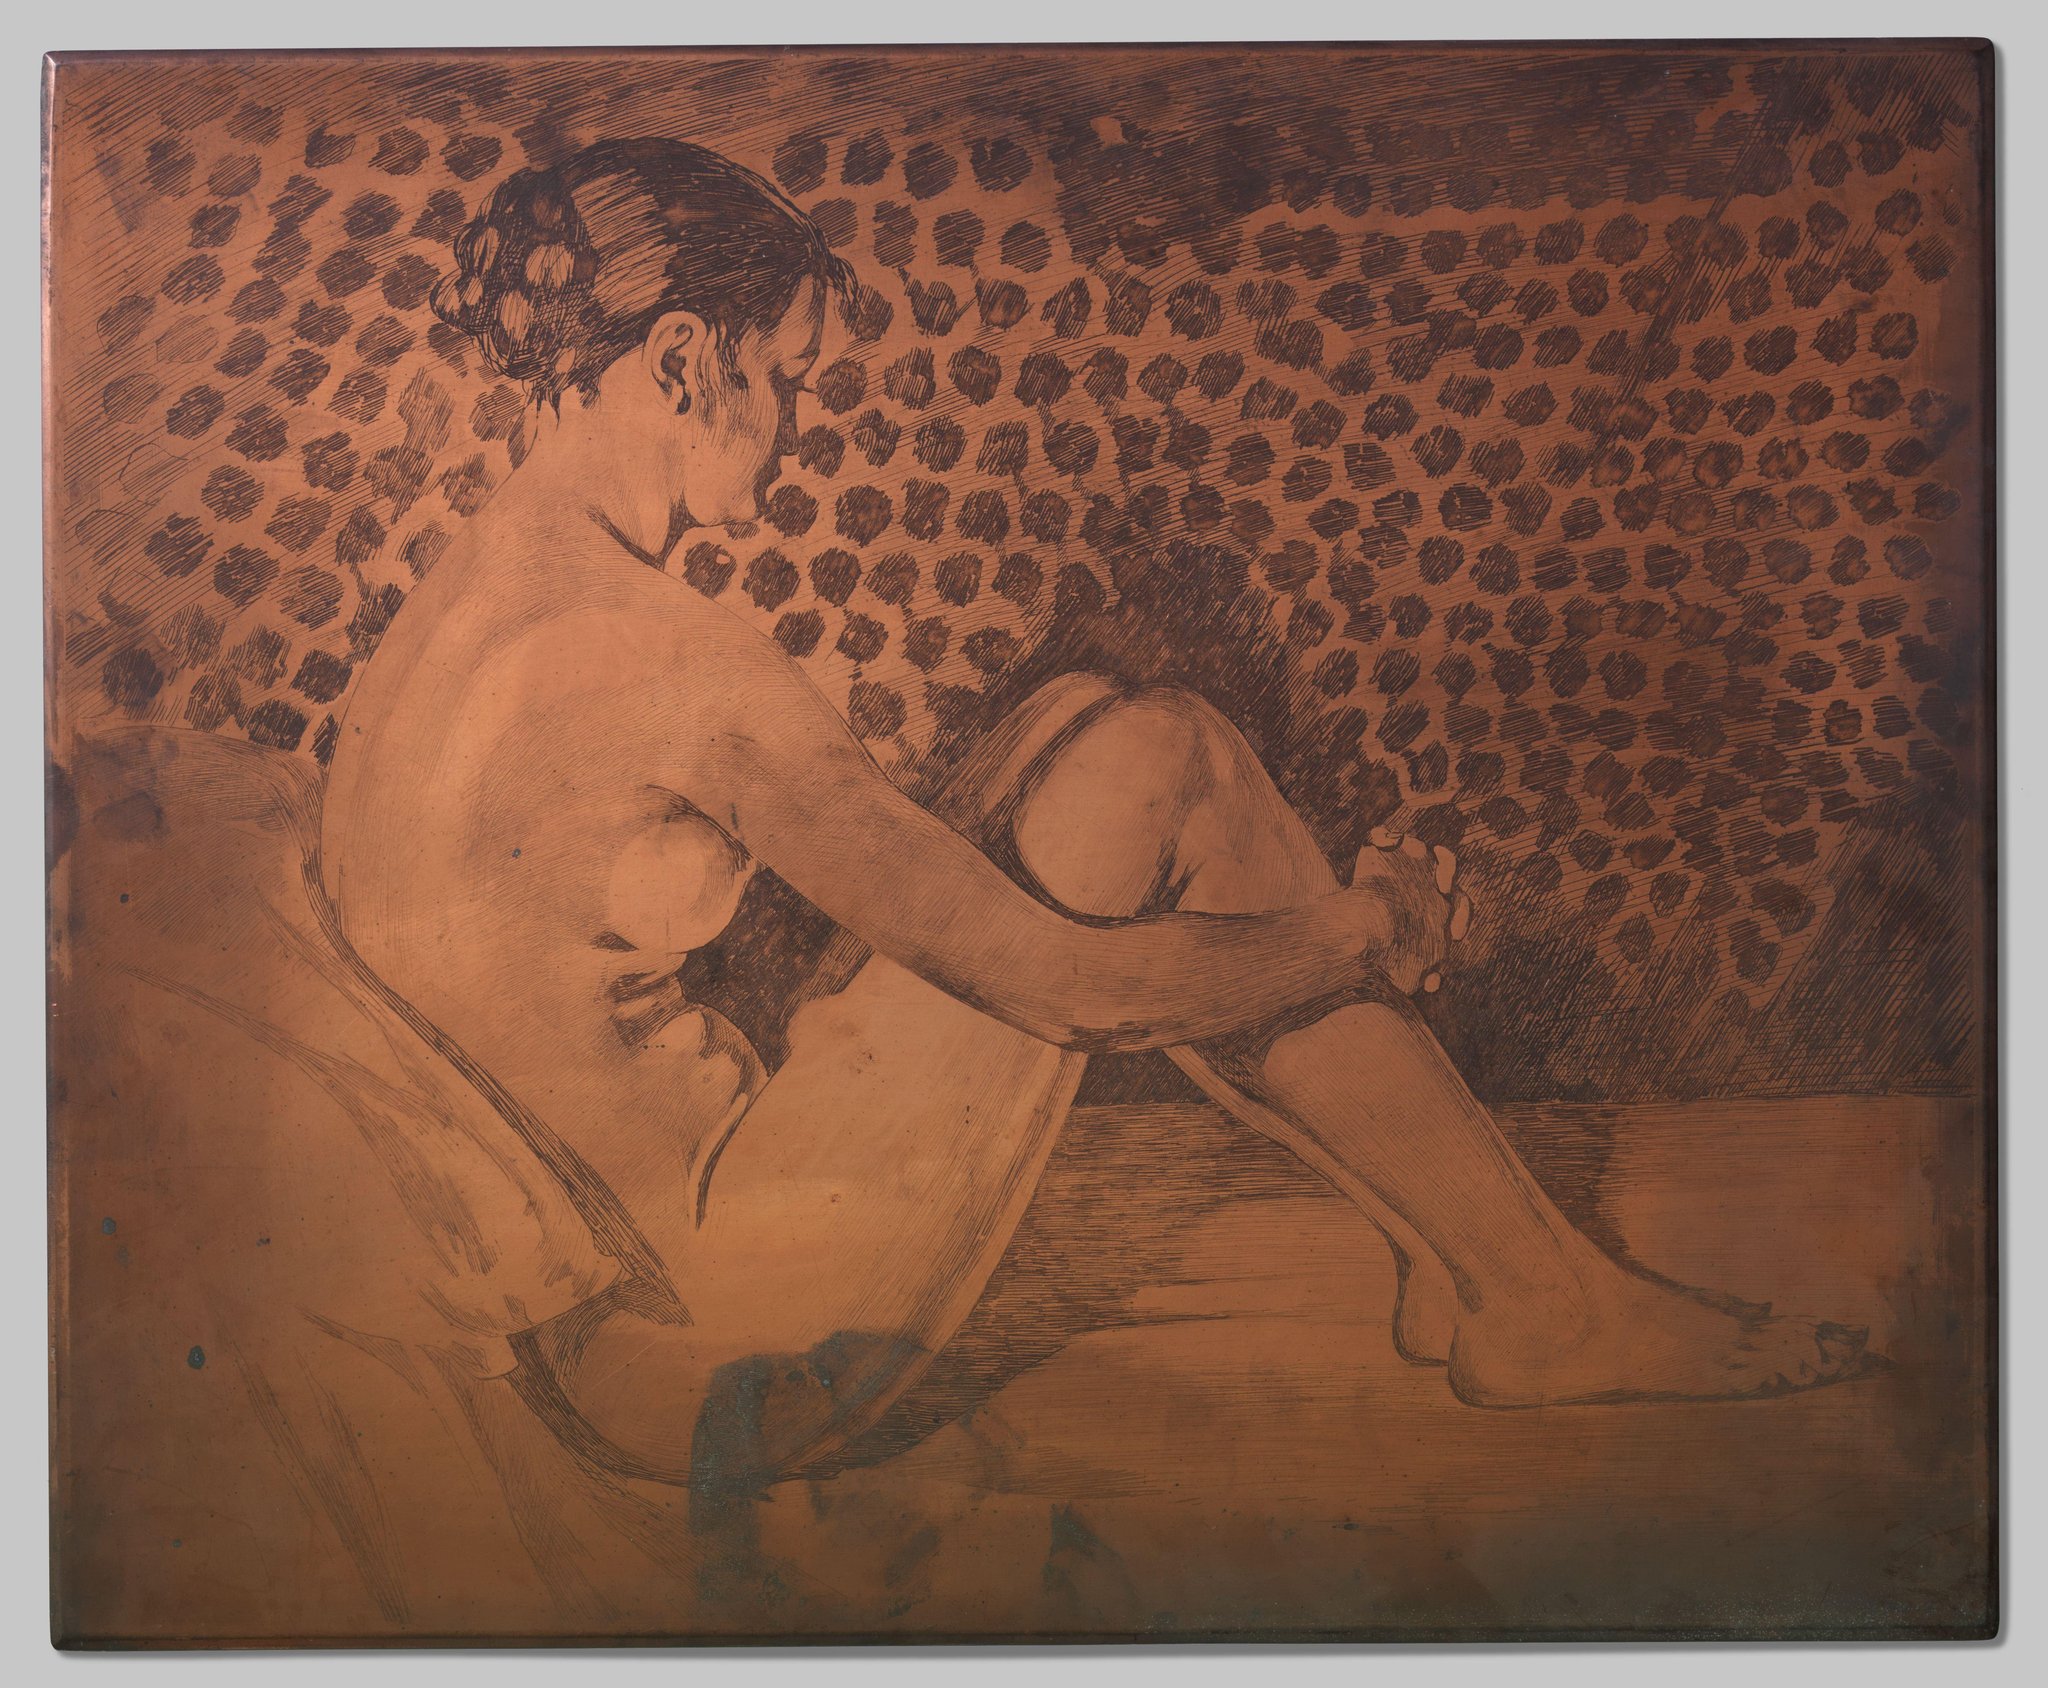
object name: copper plate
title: Naakt, zittend op divan met opgetrokken knieën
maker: willem witsen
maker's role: draughtsman, painter, print maker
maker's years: 1860-1923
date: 1922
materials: copper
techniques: etching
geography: amsterdam